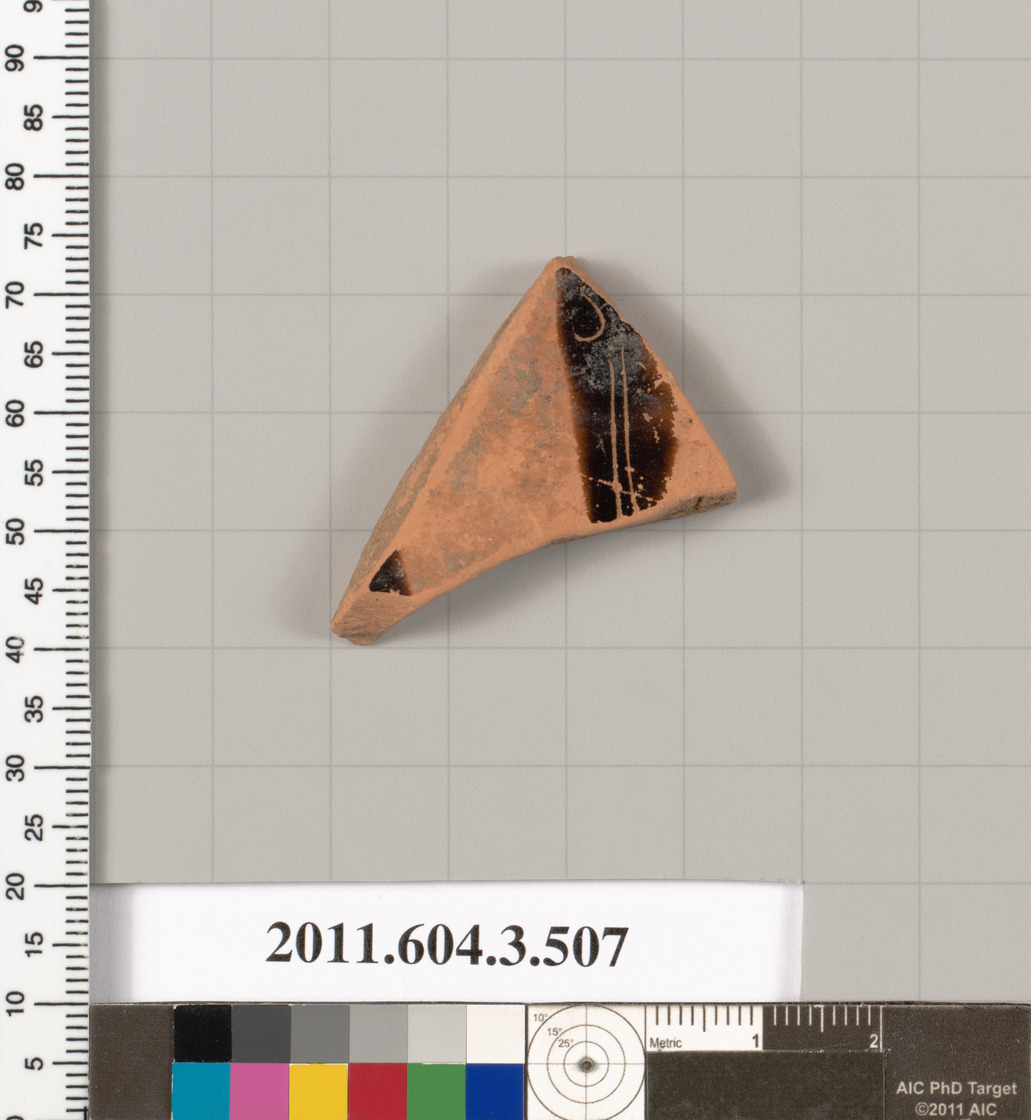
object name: column krater fragment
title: Terracotta fragment of a column-krater (bowl for mixing wine and water)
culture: greek, attic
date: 534-468 BCE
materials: terracotta